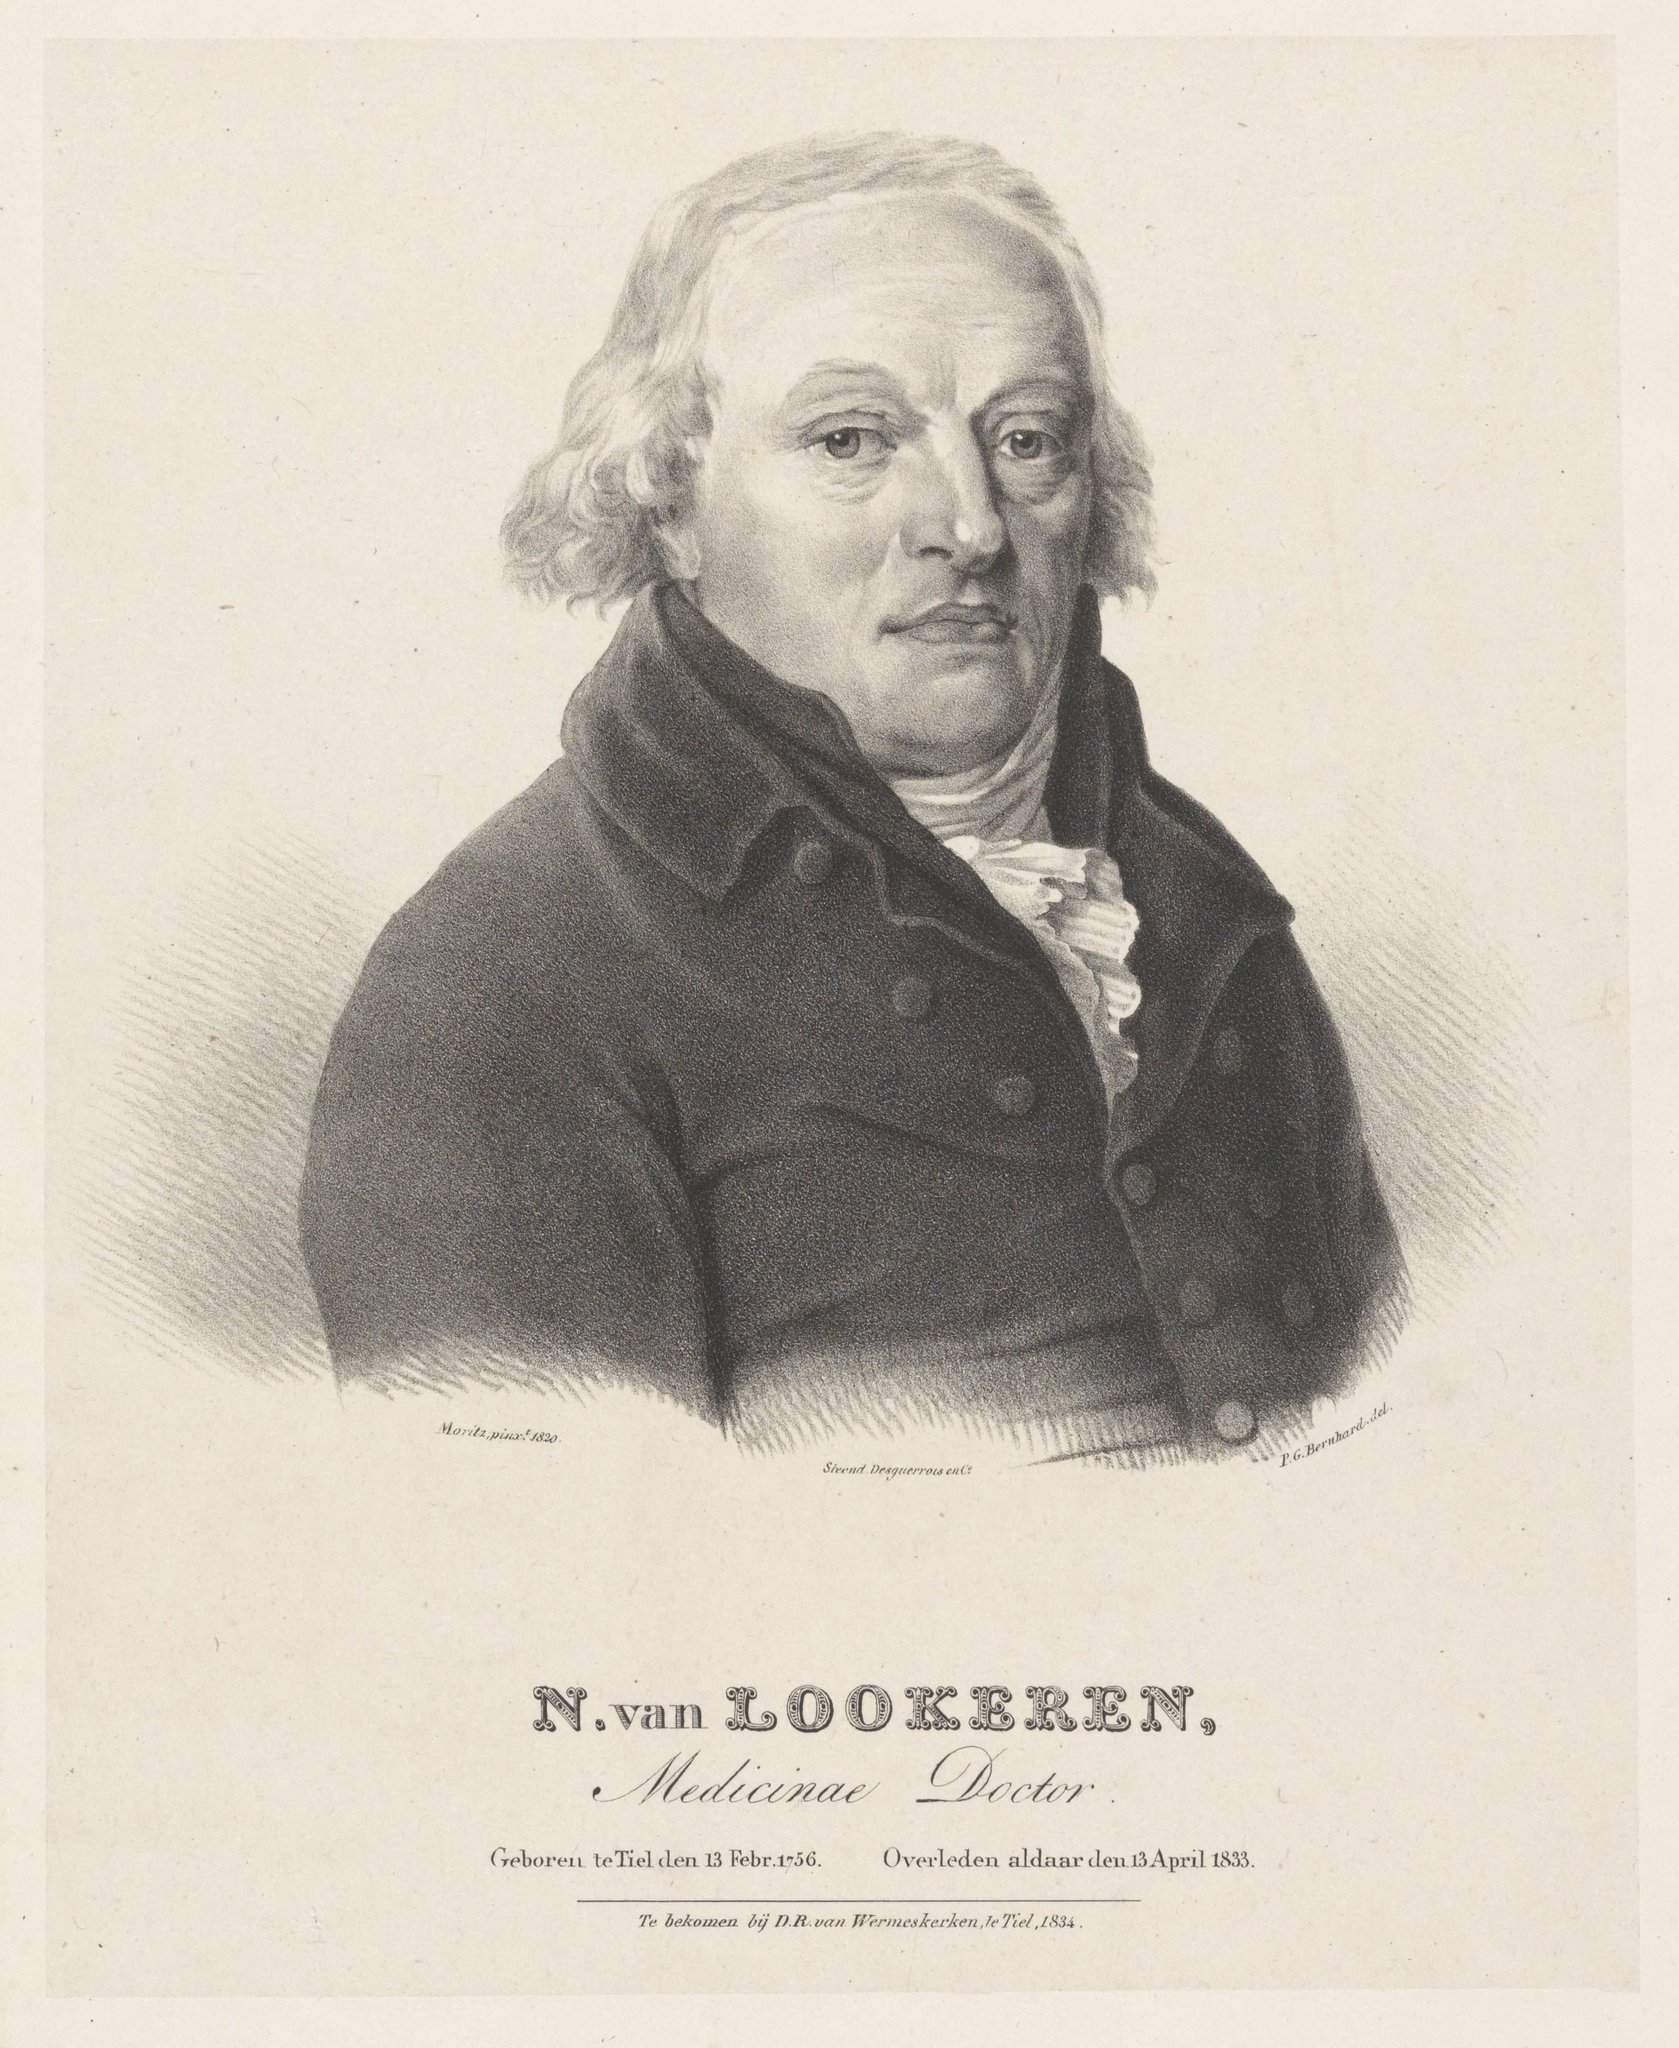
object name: print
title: Portret van Nicolaas van Lookeren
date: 1834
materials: paper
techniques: lithograph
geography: the hague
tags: historical persons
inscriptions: collector's mark: Lugt 2228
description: Onder het portret de naam, het beroep en de gebeboorte- en sterfdatum van de geportretteerde.